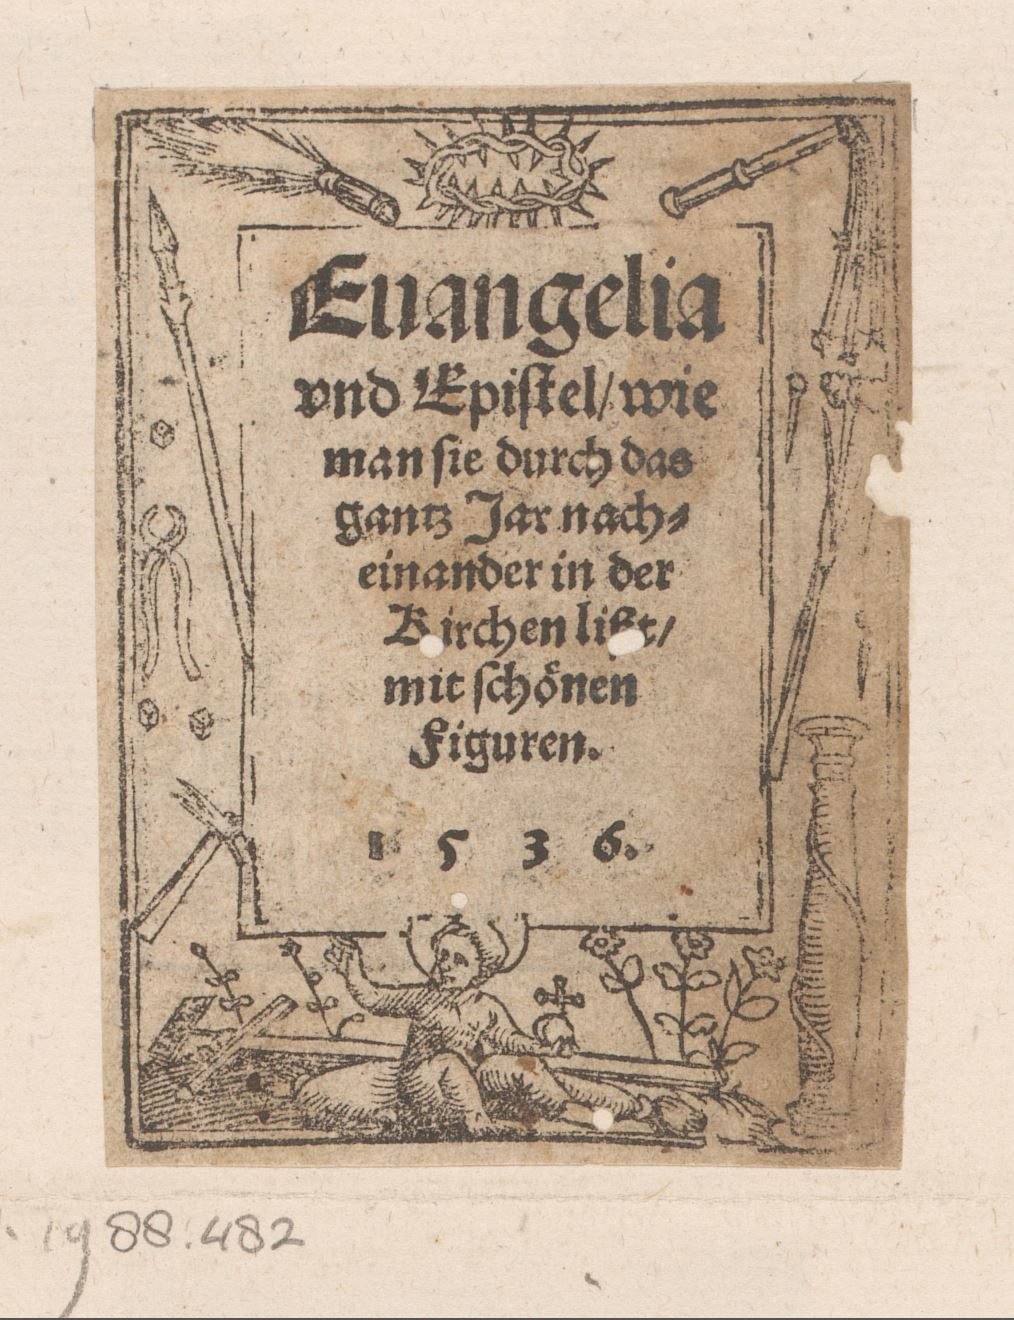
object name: print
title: Omlijsting met het Christuskind en passiewerktuigen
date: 1536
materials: paper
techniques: woodcut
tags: title-page, christ-child surrounded by the instruments of the passion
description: Titelpagina voor: Evangelia und Epistel. Neurenberg: Hans Guldenmund, 1536.